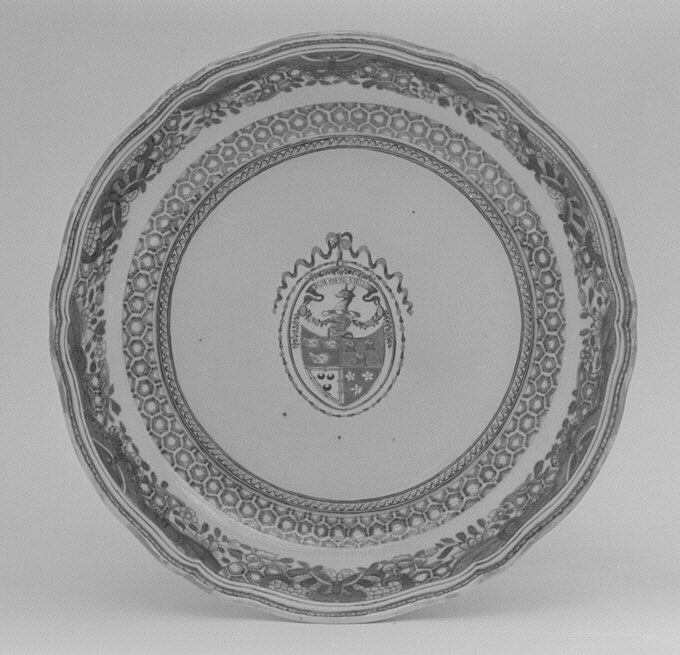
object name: dish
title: Deep dish (part of a service)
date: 1770-1785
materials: hard paste porcelain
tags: coat of arms